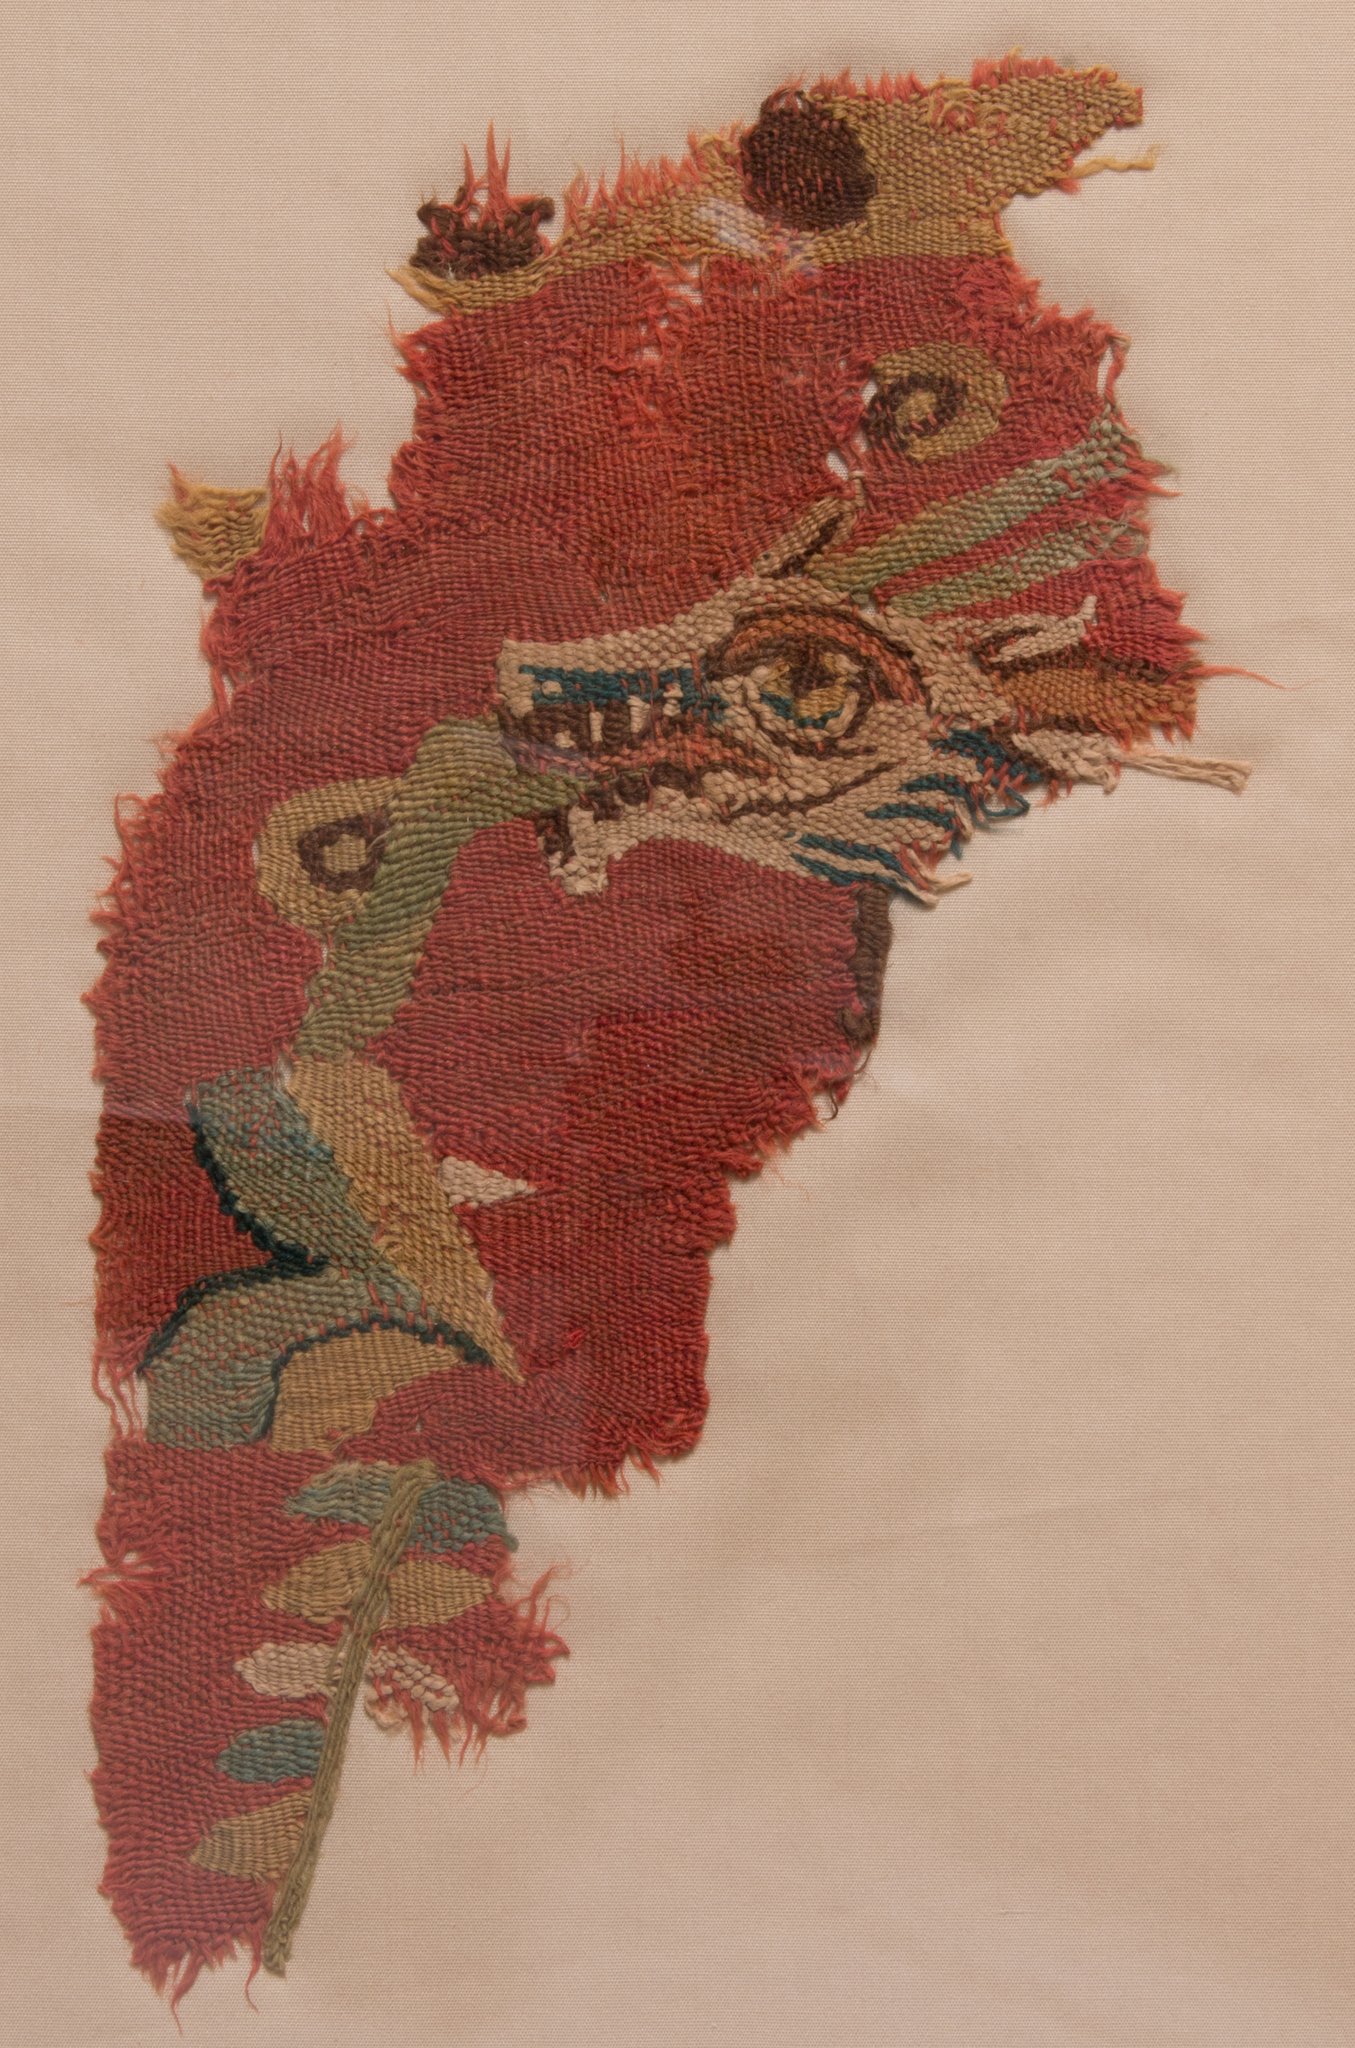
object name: textile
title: Wool Roundel with Mythological Animal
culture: egyptian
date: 601-900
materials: linen, wool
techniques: polychrome, weave